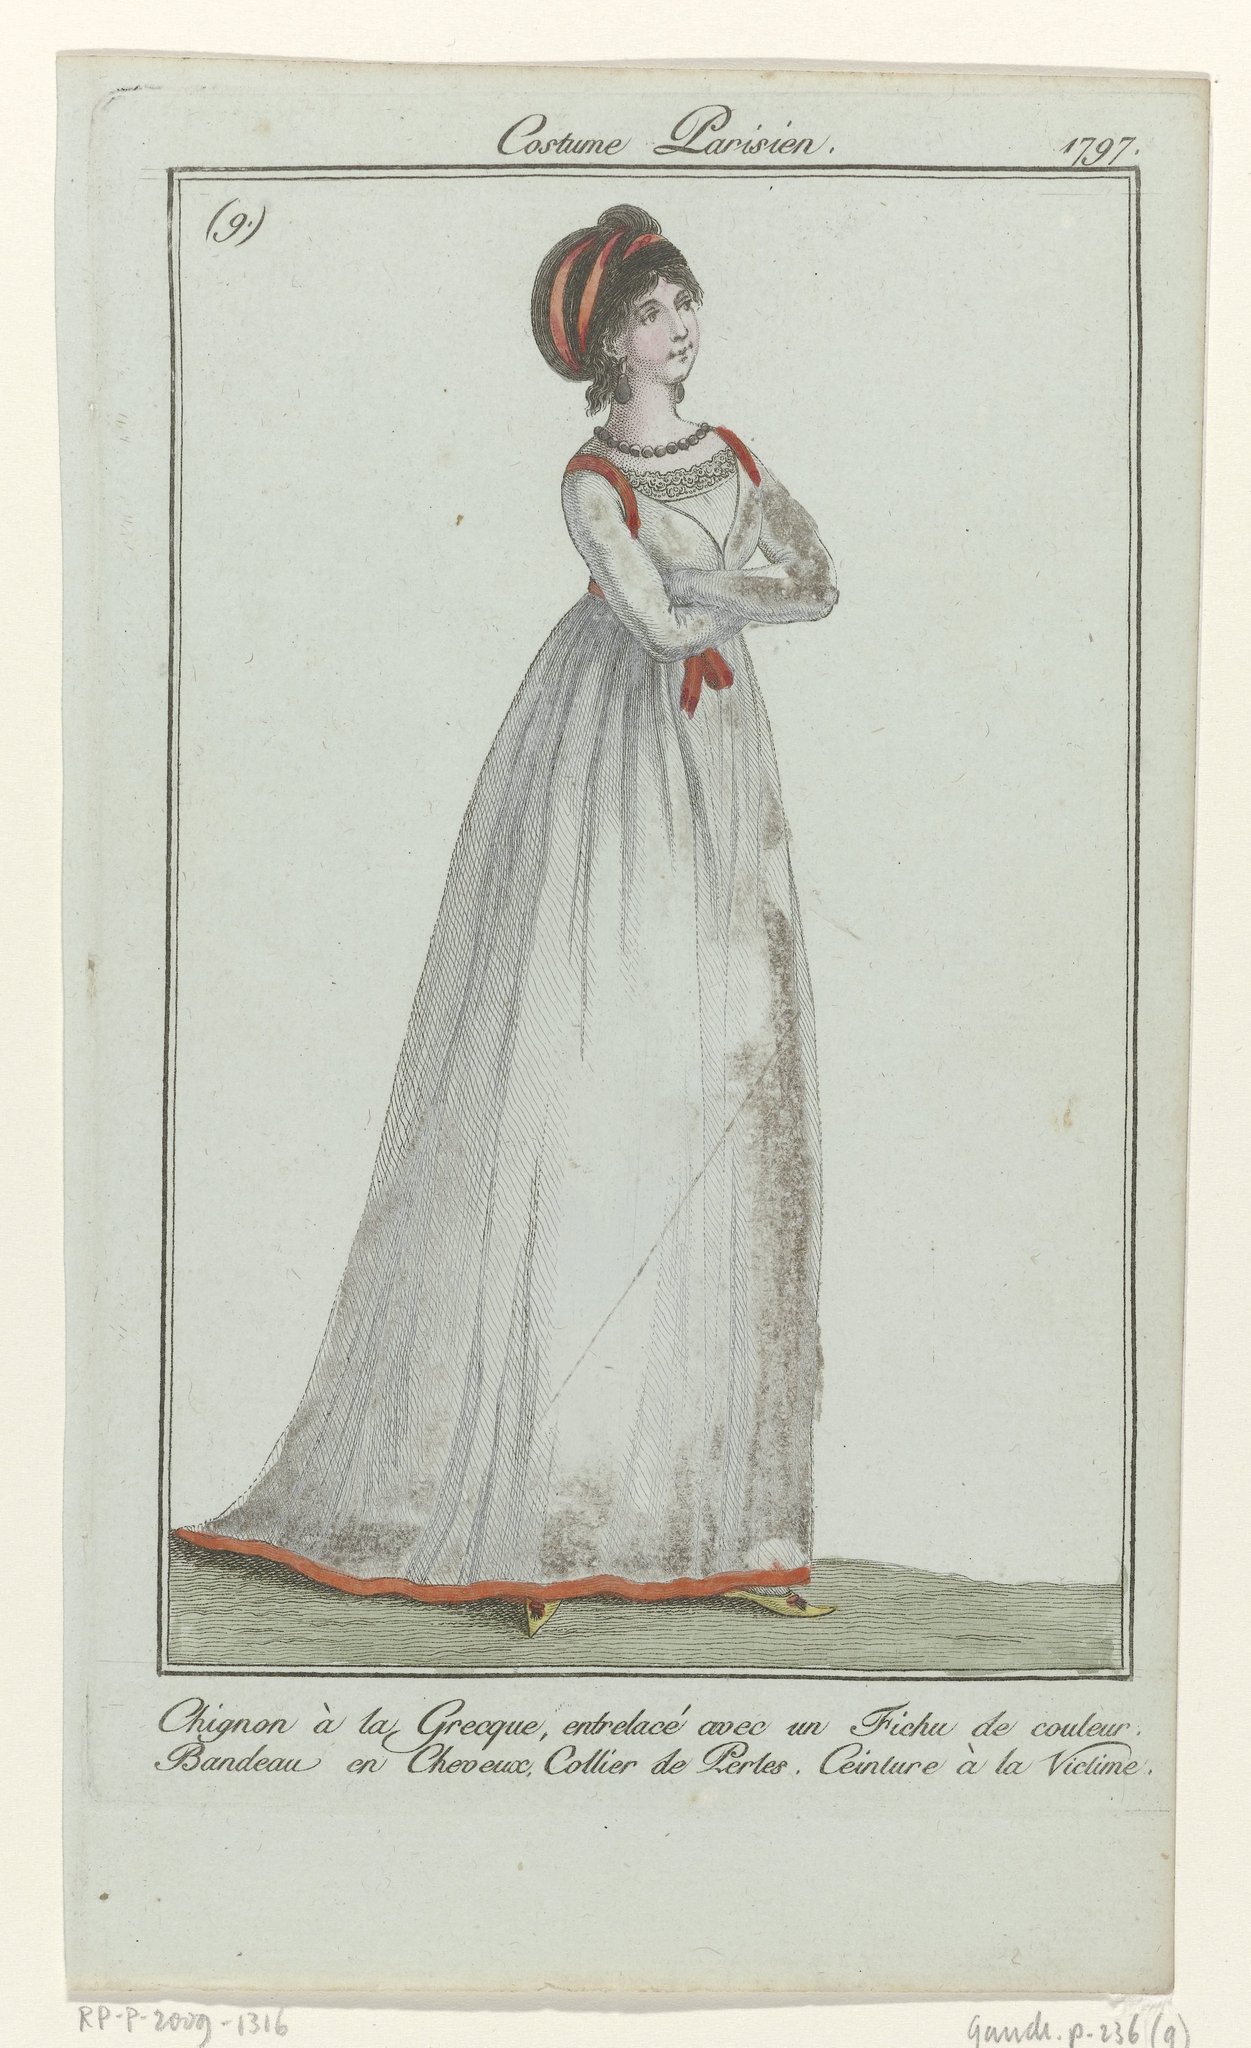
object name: fashion print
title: Journal des Dames et des Modes, Costume Parisien, 4 novembre 1797, (9) : Chignon à la Grecqu (...)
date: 1797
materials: paper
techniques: engraving, hand coloring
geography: paris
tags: ear-rings (+ women's clothes), styles of hairdress - aa - ~ women, fashion plates, shoes, sandals (+ women's clothes), dress, gown (+ women's clothes), piece of clothing covering the breast or décolleté (fichu) (+ women's clothes), belt, girdle, waistband (+ women's clothes), pearl; pearl necklace (+ women's clothes)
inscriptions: caption: ‘Chignon à la Grecque, entrelacé avec un Fichu de couleur. Bandeau en Cheveux. Collier de Perles. Ceinture à la Victime.’, title: ‘Costume Parisien.’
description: Japon met lange mouwen en een ceintuur 'à la Victime'. Het haar is in een knot, ineengevlochten met een gekleurde fichu: 'Chignon à la Grecque'. Haarband in het haar. Verdere accessoires: oorbellen, parelcollier, platte schoenen met puntige neuzen. De prent maakt deel uit van het modetijdschrift Journal des Dames et des Modes, uitgegeven door Sellèque, Parijs, 1797-1839.